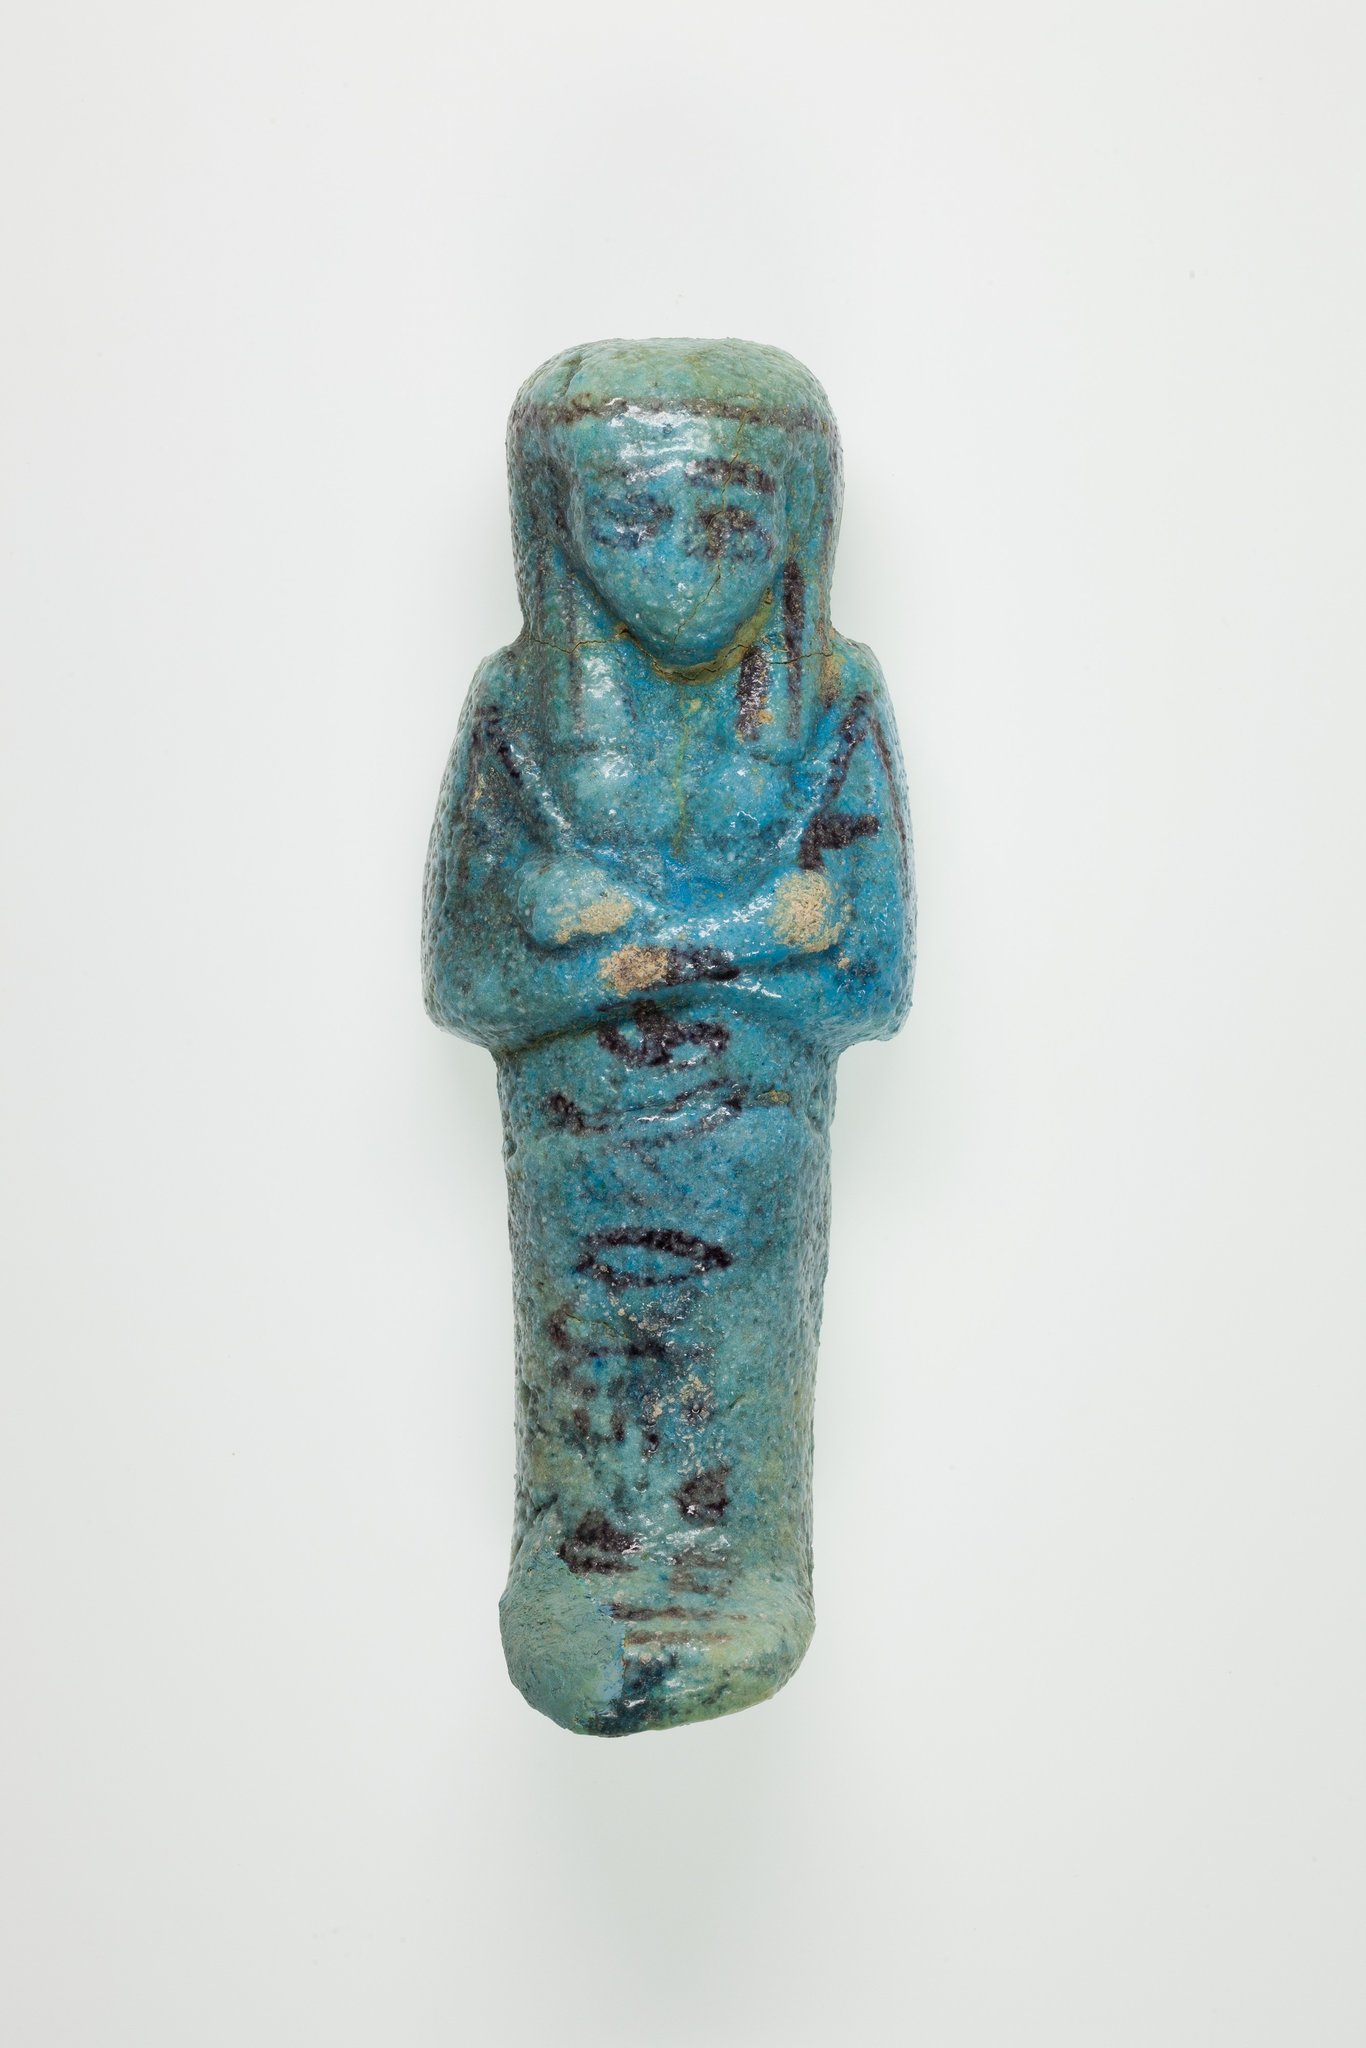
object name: shabti, henettawy c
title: Worker Shabti of Henettawy (C), Daughter of Isetemkheb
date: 990-970 BCE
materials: faience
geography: egypt